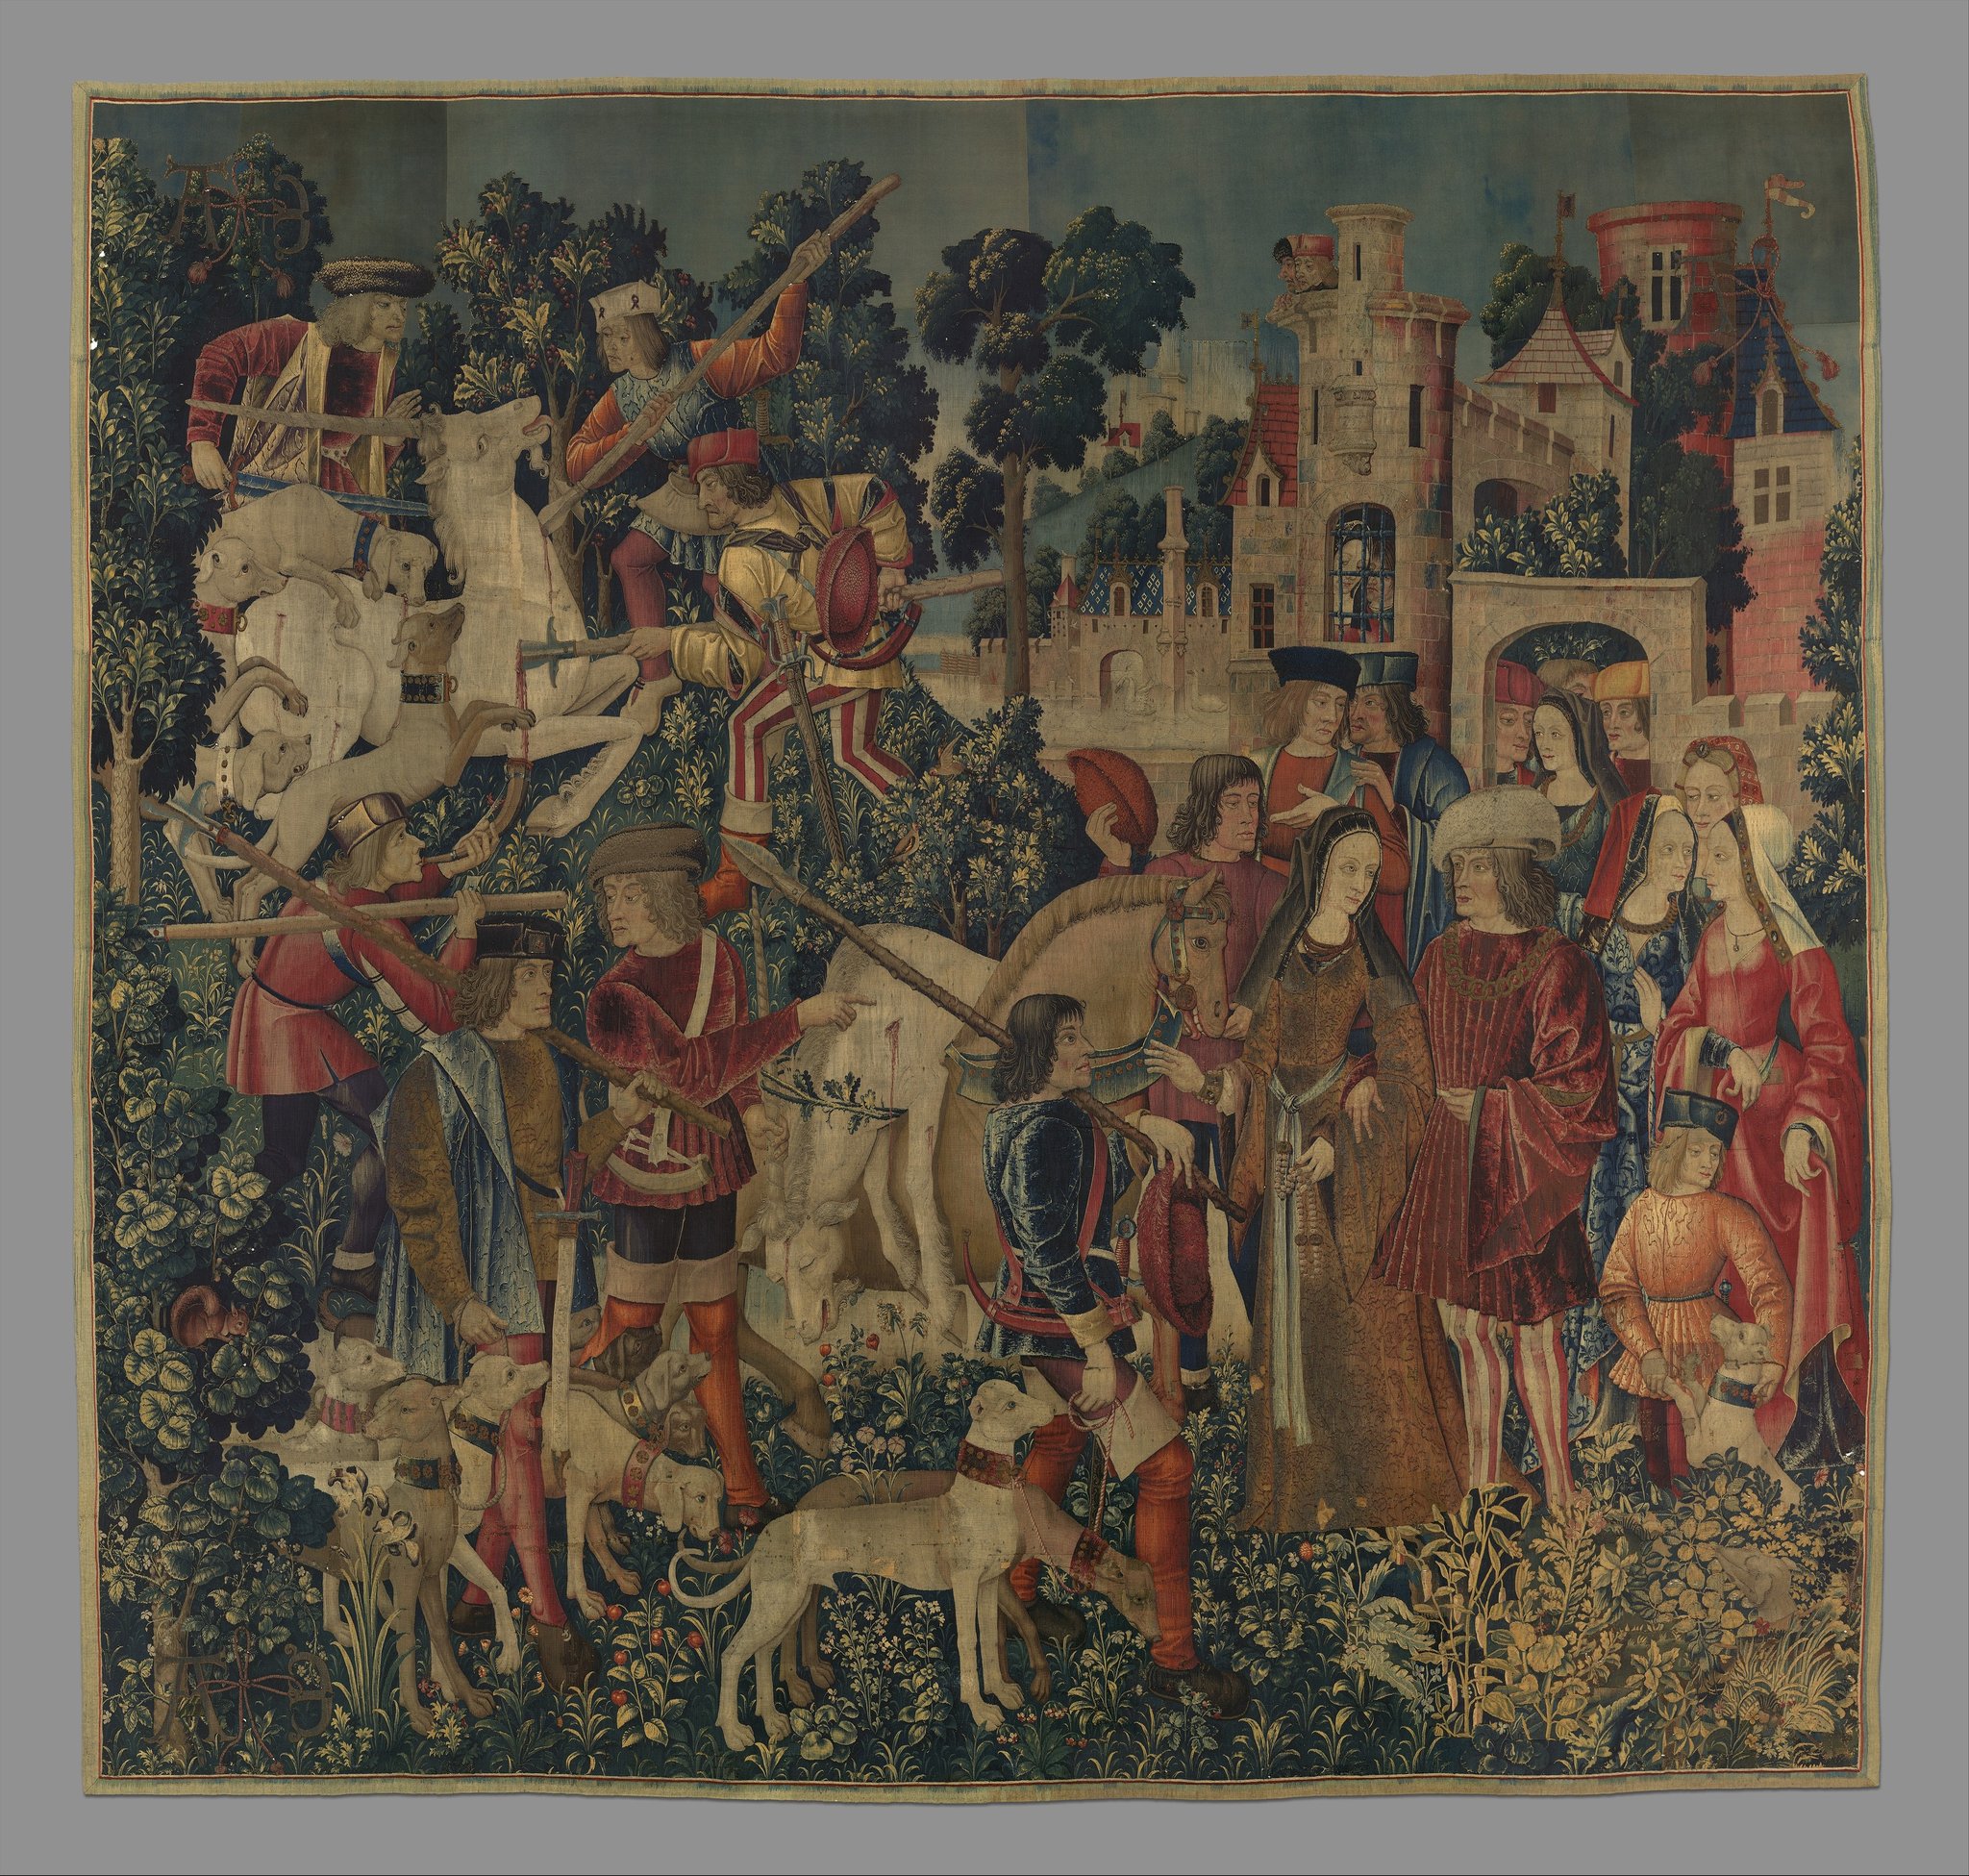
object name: tapestry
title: The Hunters Return to the Castle (from the Unicorn Tapestries)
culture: french or south netherlandish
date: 1495-1505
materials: gilt, silk, silver, wool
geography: netherlands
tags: castles,spears,men,women,unicorns,dogs,horses,squirrels,death